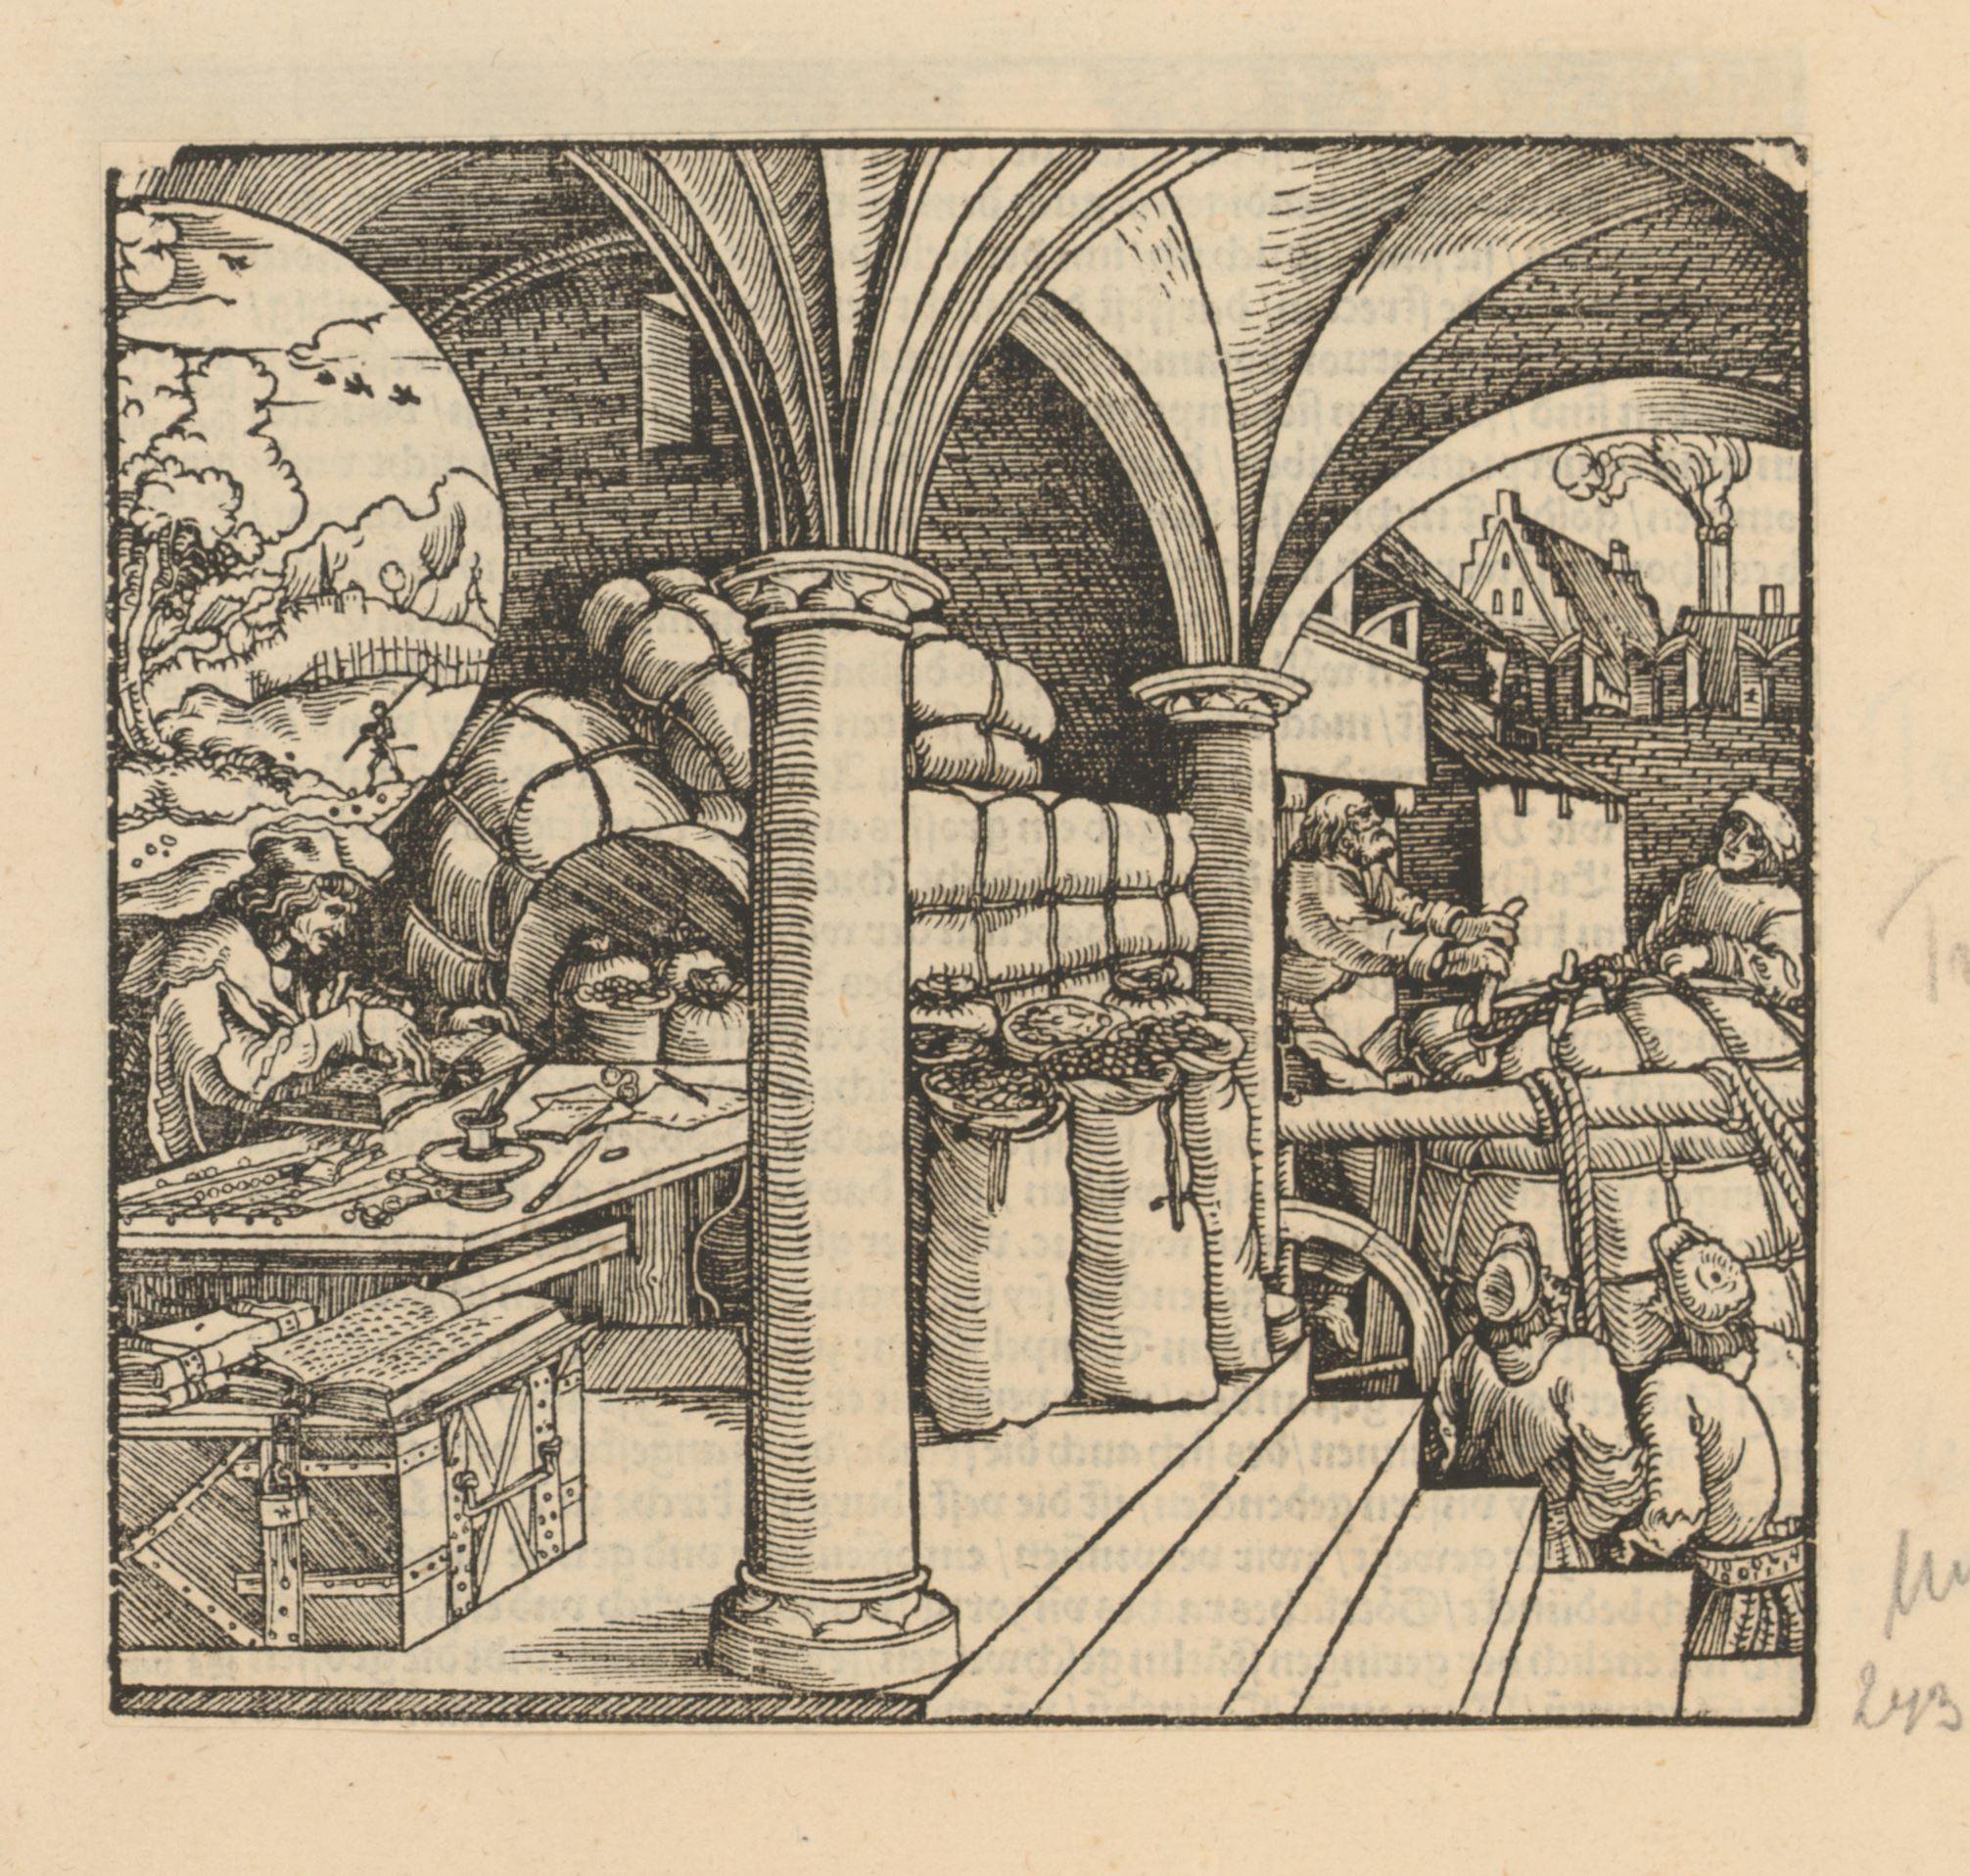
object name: album leaf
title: Man aan het werk in een keldergewelf waar zakken geld zijn opgeslagen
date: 1514-1532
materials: paper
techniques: letterpress printing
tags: banker, money-lender, usurer, abacus, counting-frame, vault ~ architecture, merchant, salesman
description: Deze prent is gebruikt in: Petrarca, Francesco. Von der Artzney bayder Glück, des guten und widerwertigen: unnd weß sich ain yeder inn Gelück und Unglück halten sol (...). Augsburg: Heinrich Steiner, 1532. Deze uitgave is ook bekend onder de titel 'Trostspiegel in Glück und Unglück'. Deze prent is ook gebruikt in: Cicero, Marcus Tulius. Officia M.T.C. Ein Buch so Marcus Tullius Cicero der Römer zu seynem (...). [Vertaald uit het Latijn door] Johann von Schwarzenberg. Augsburg: Heinrich Steiner, 1531.